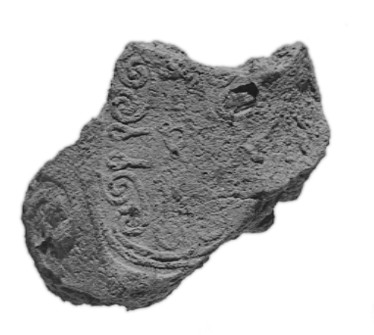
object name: sealing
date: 2030-1640 BCE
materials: clay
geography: egypt